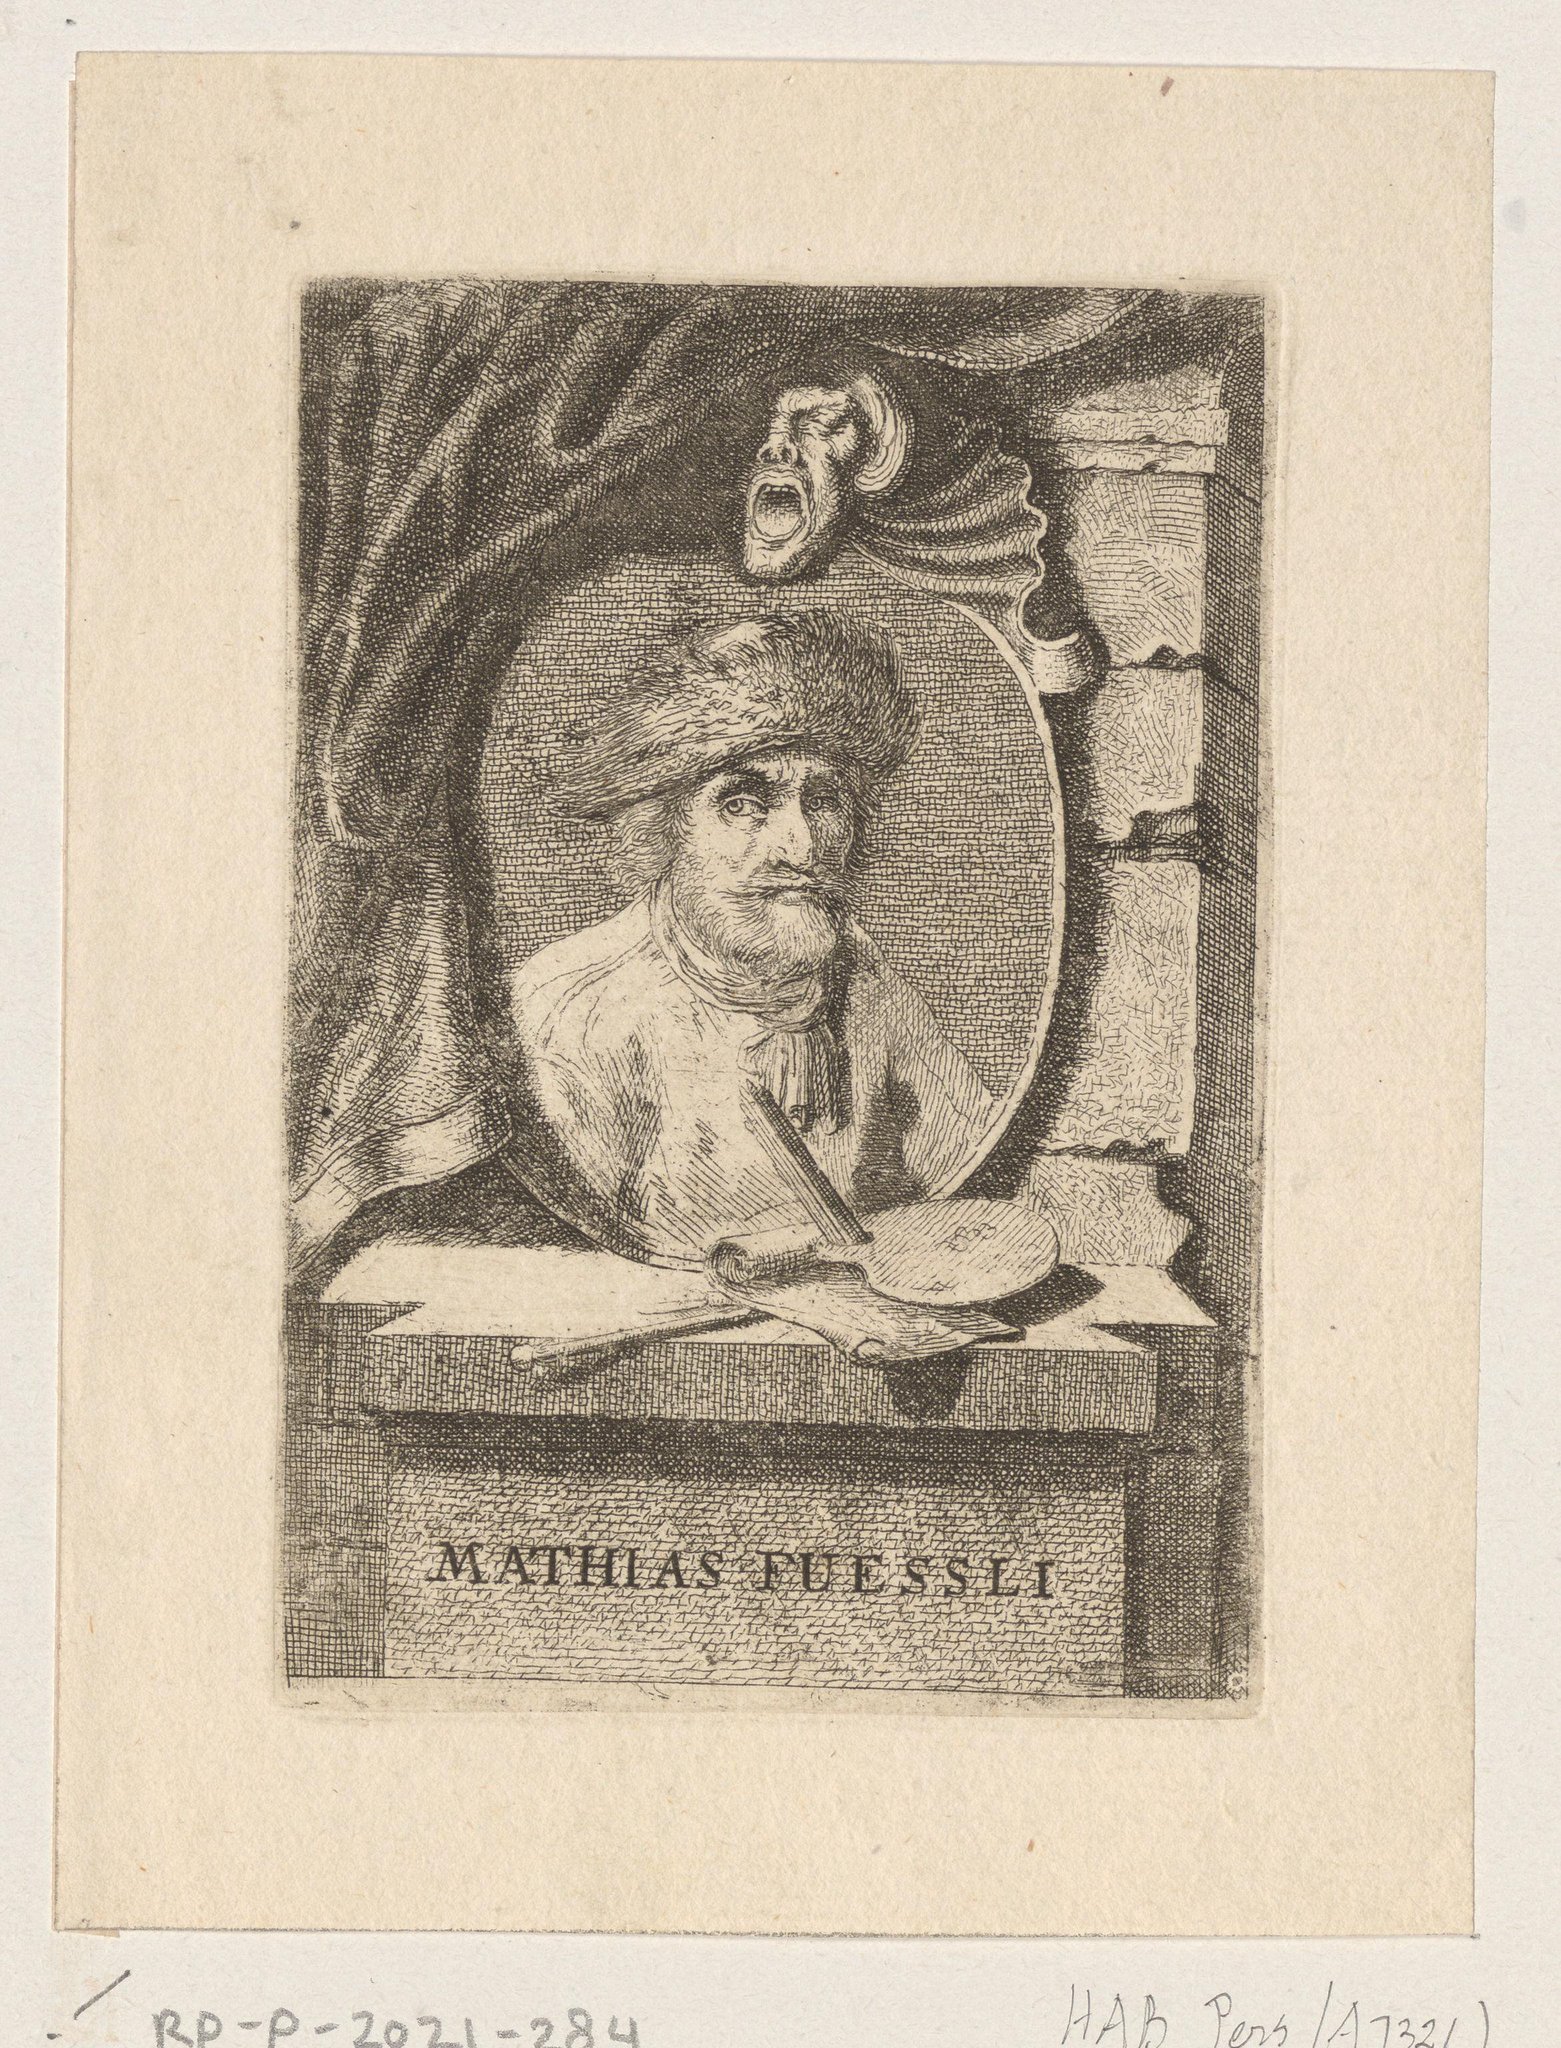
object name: print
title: Portret van Mathias Füssli (I)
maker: Anonymous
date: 1700-1799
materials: paper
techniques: etching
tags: mathias füssli (i), ornament ~ medallion, historical persons, scallop, shell ~ ornament, portrait, self-portrait of artist, palette